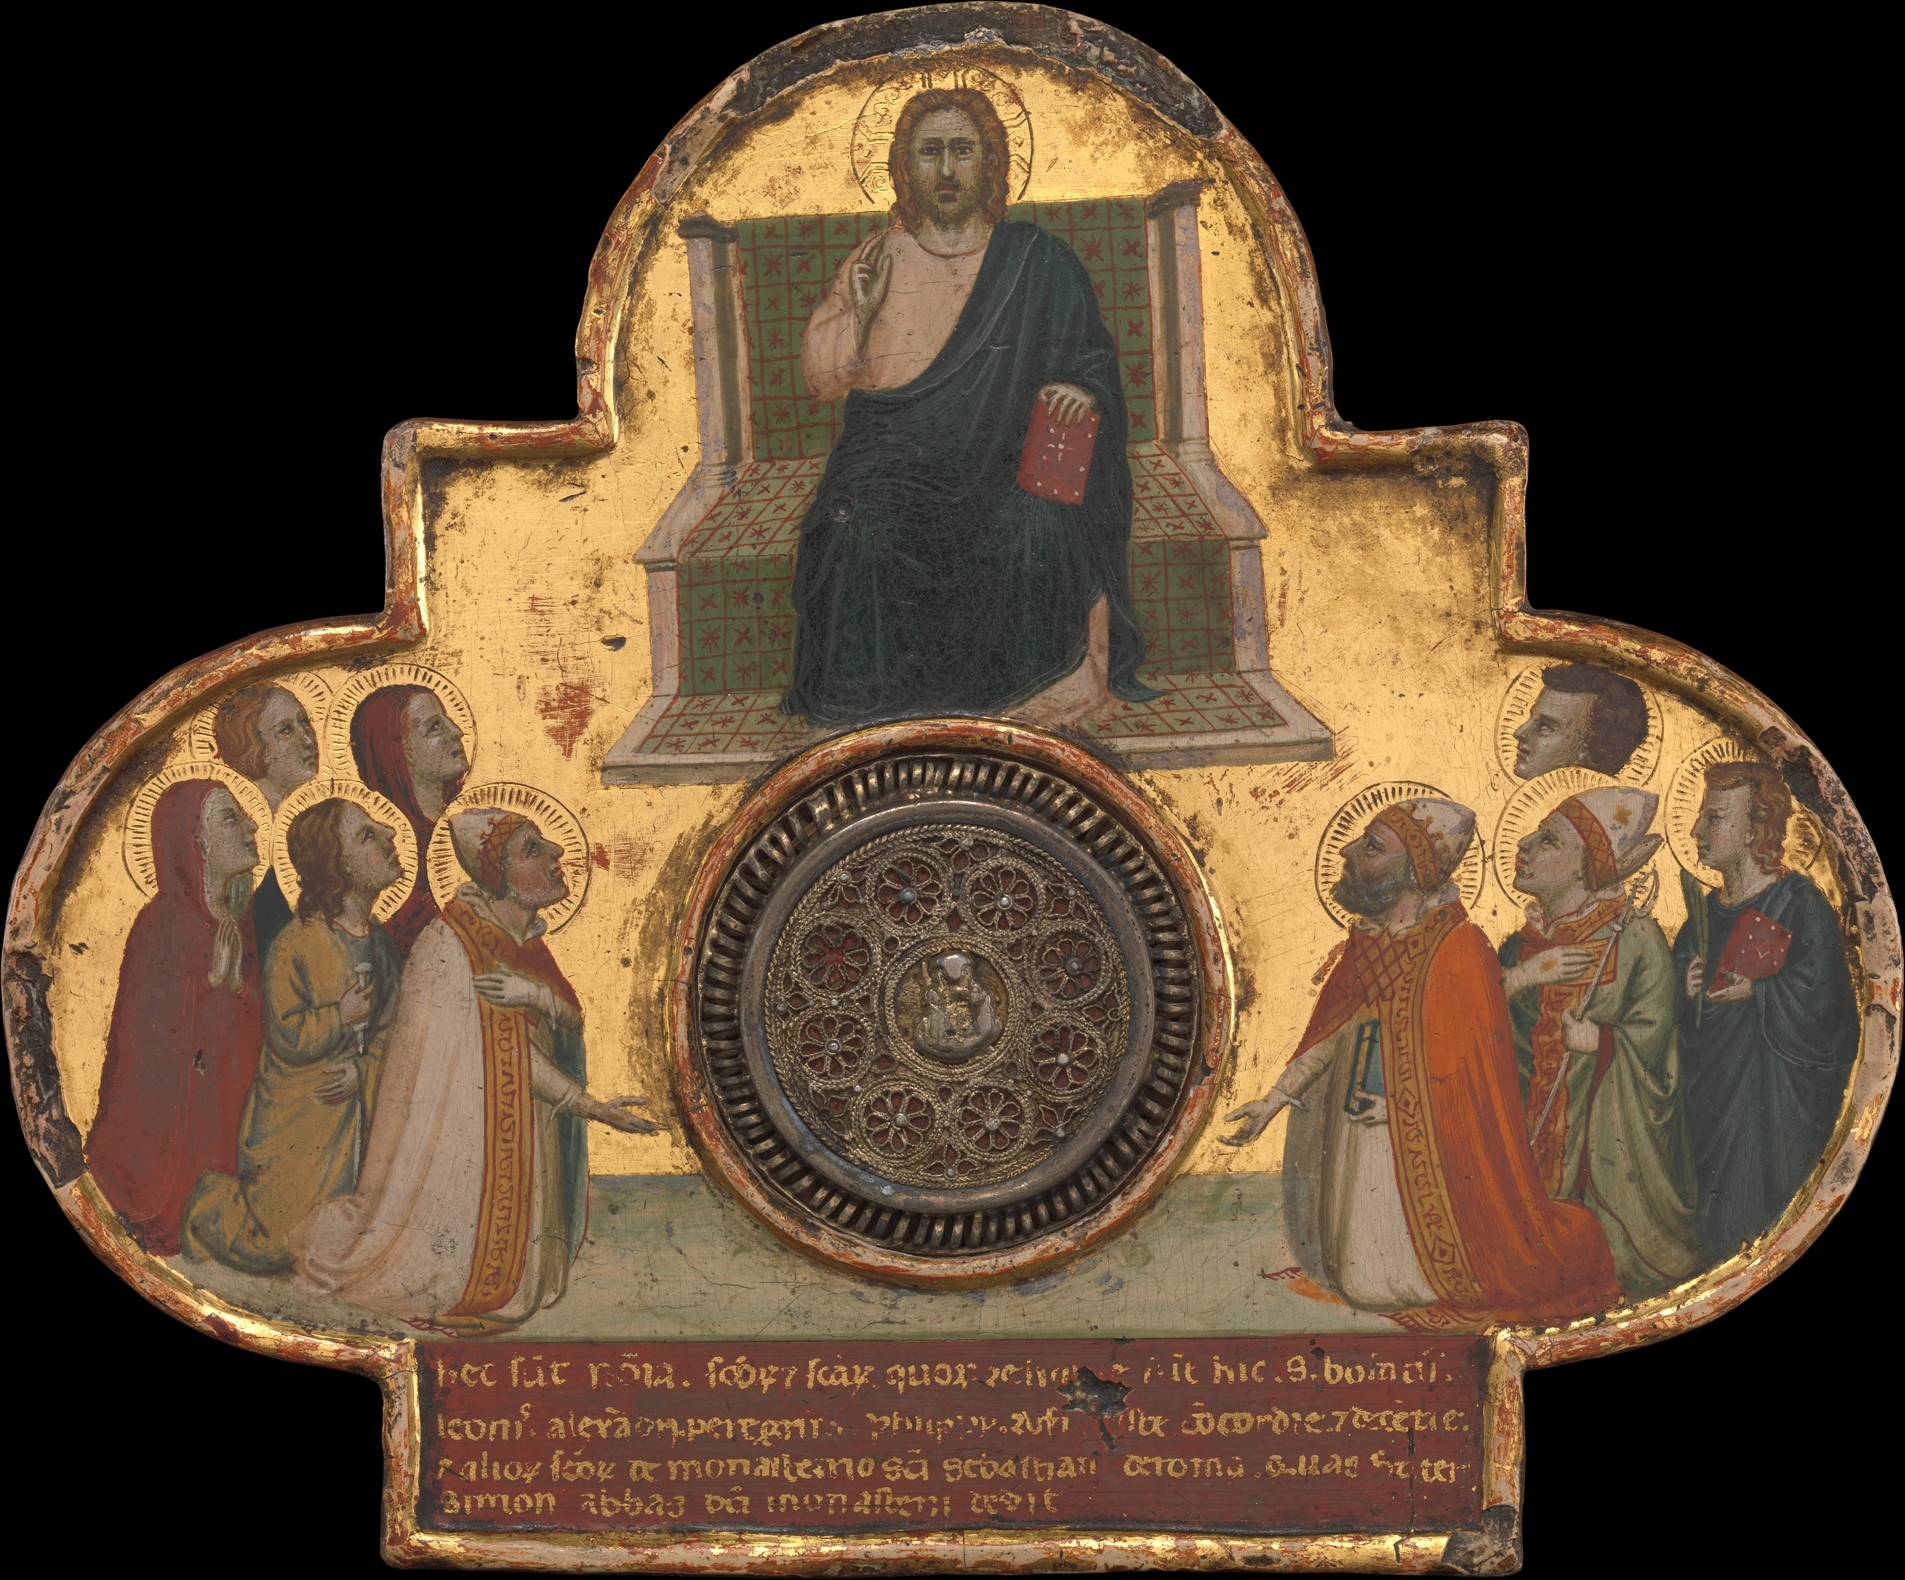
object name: painting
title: Christ Enthroned with Saints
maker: bernardo daddi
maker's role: artist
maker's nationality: italian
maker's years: 1290-1348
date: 1325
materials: gold leaf, paint, wood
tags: men,women,christ,saints